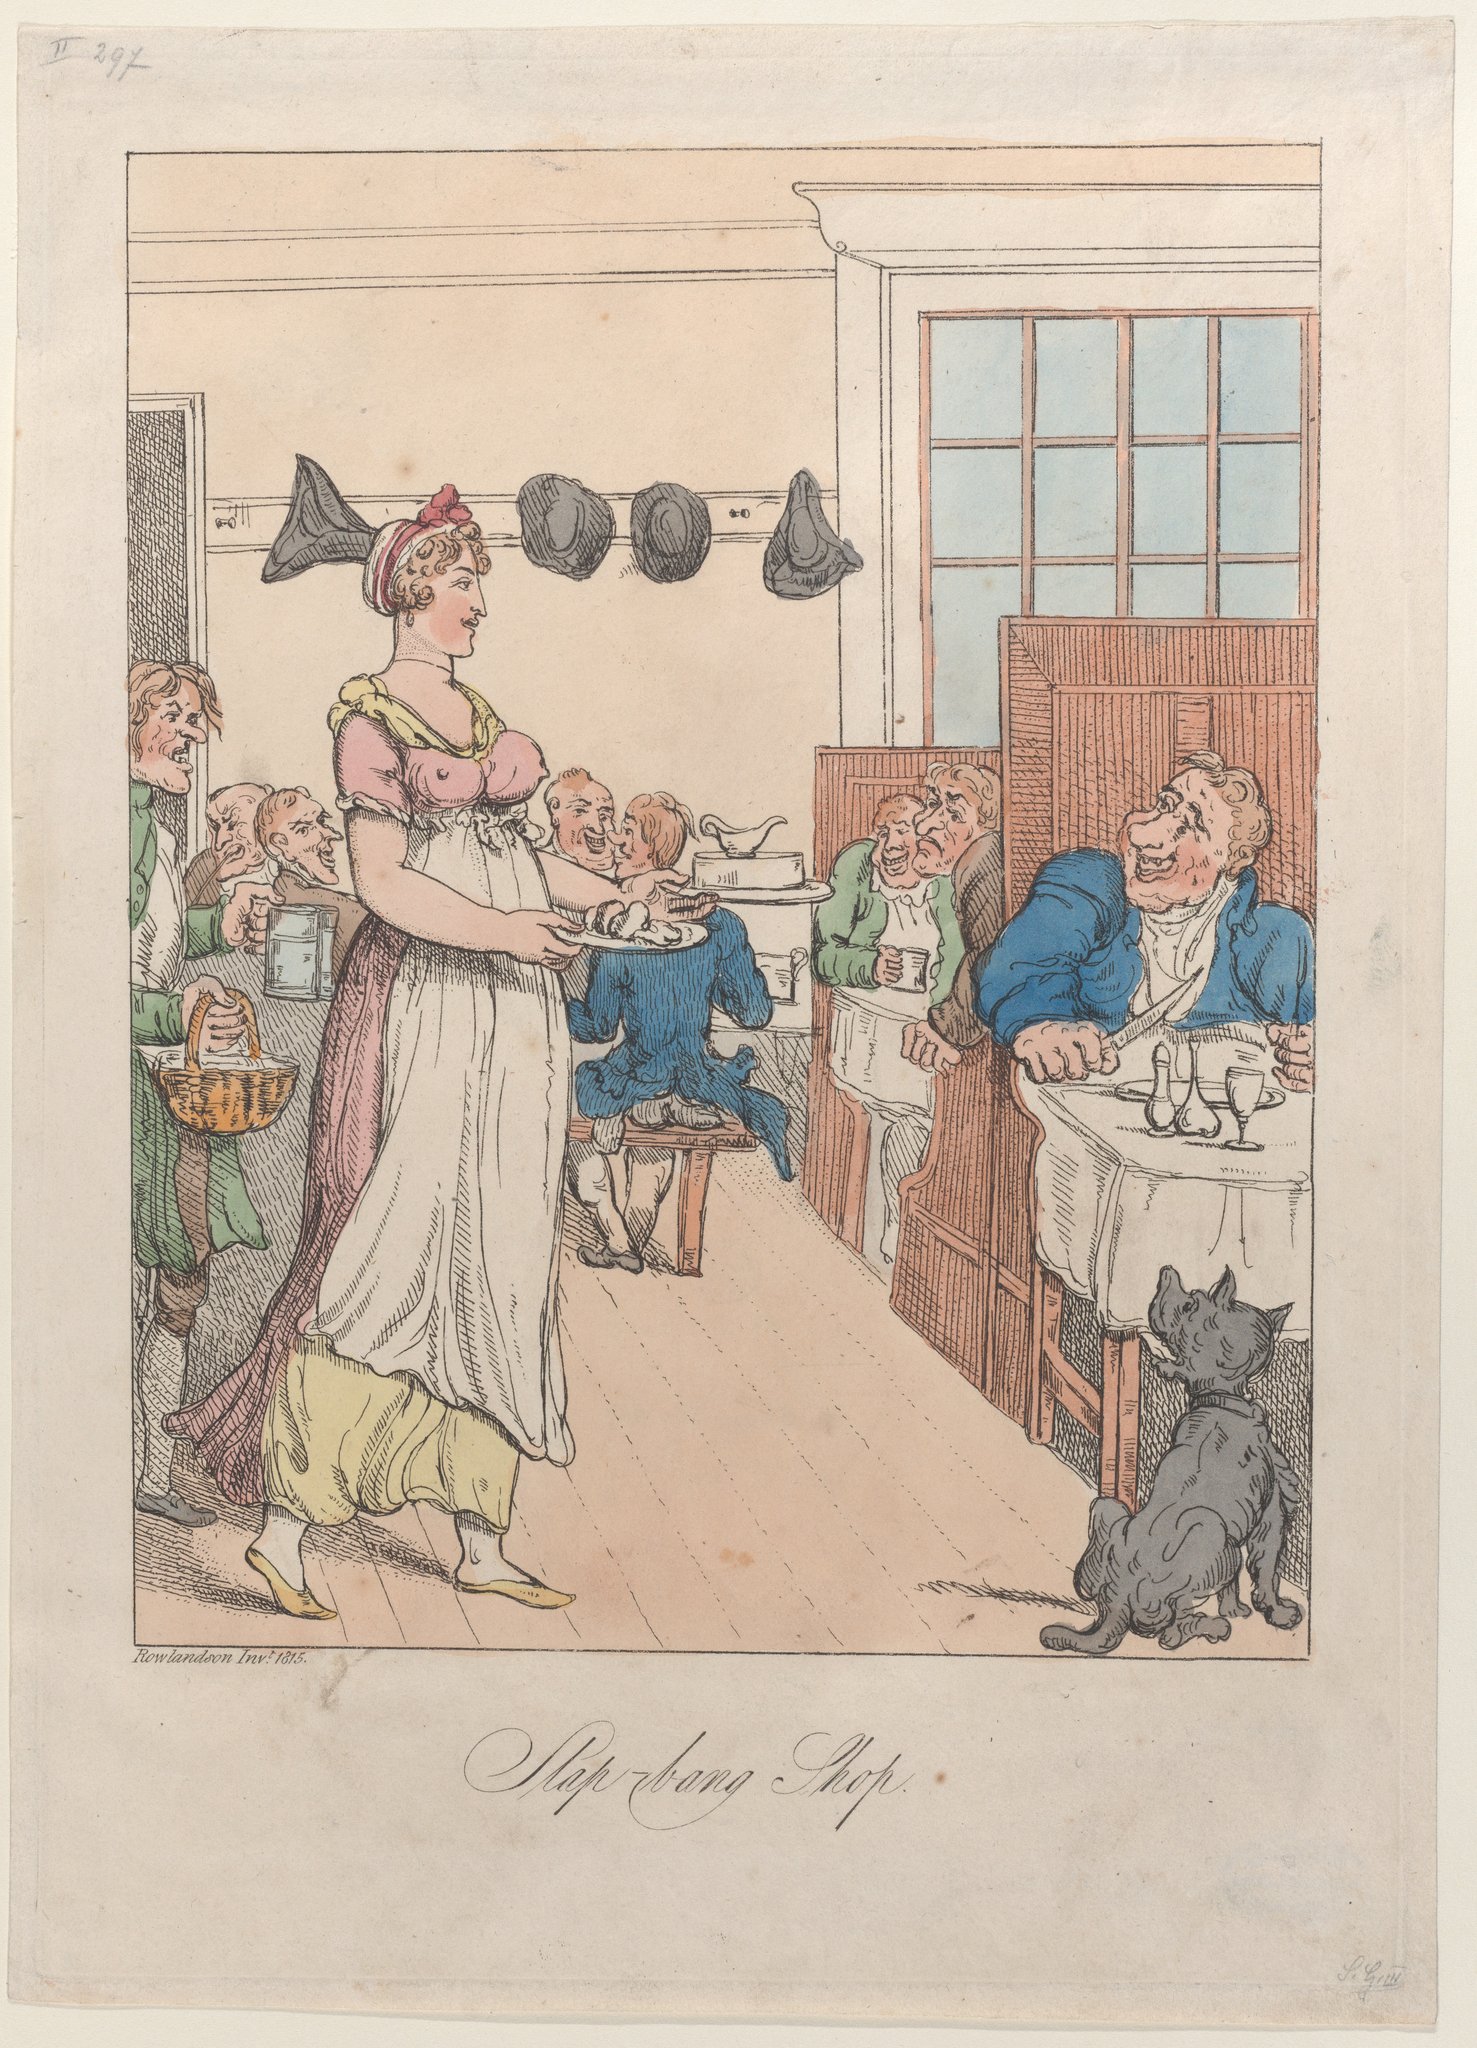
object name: print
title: Slap-Bang Shop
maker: thomas rowlandson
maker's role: artist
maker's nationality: british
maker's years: 1757-1827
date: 1815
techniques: etching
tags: satire,restaurants,men,women,dogs,dining